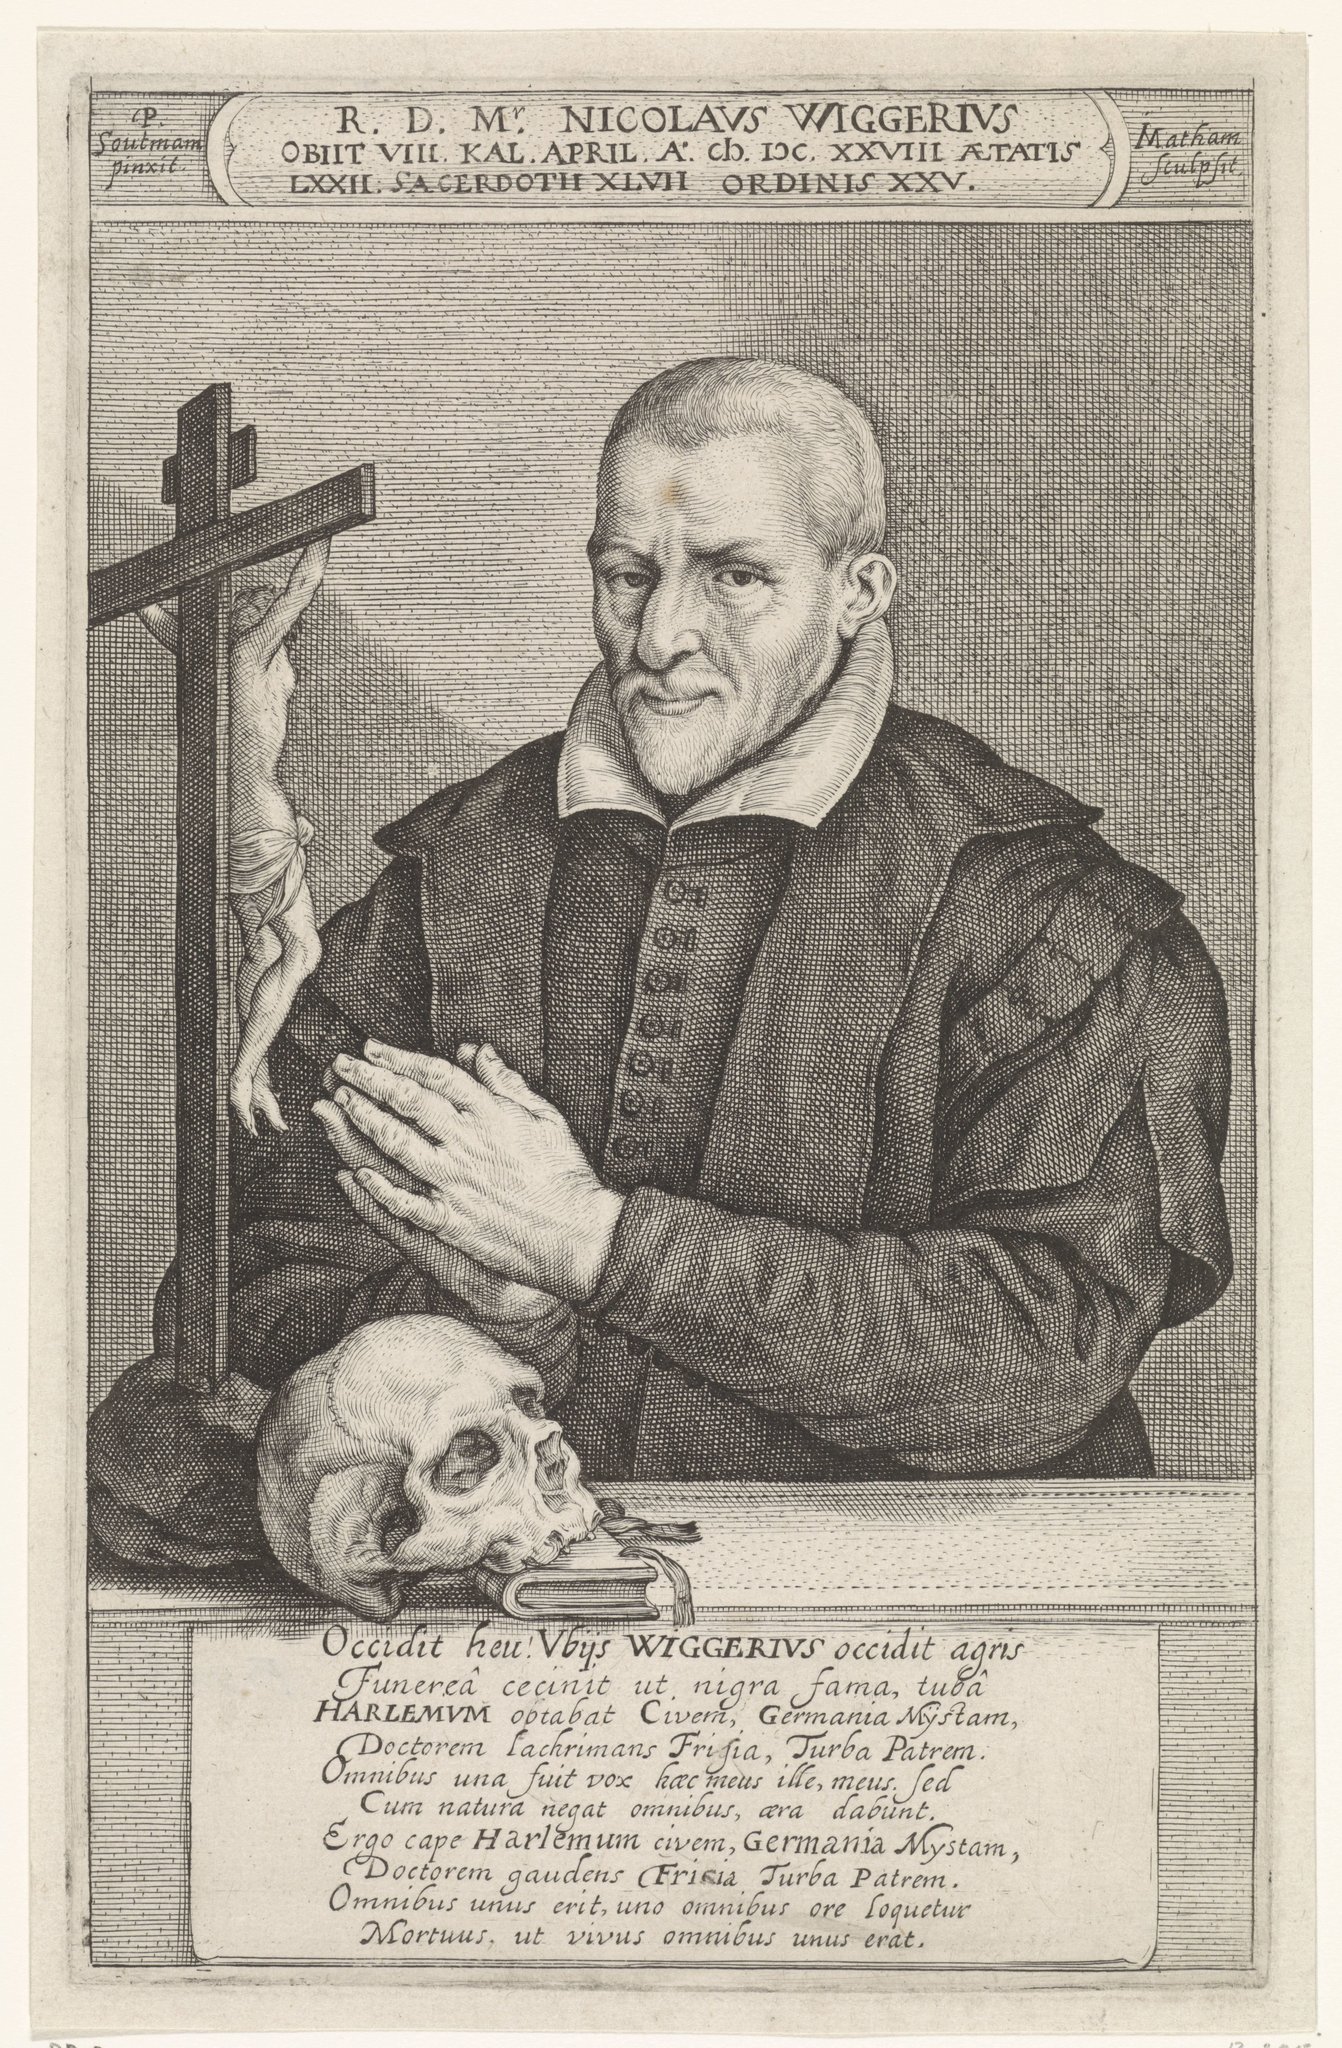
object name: print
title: Portret van Claes Wiggers Cousebant Vigerius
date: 1628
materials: paper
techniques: engraving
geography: haarlem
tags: skull as symbol of 'vanitas', crucifix ~ personal devotion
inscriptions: collector's mark: Lugt 2228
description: Portret van de priester te Haarlem Claes Wiggers Cousebant Vigerius.